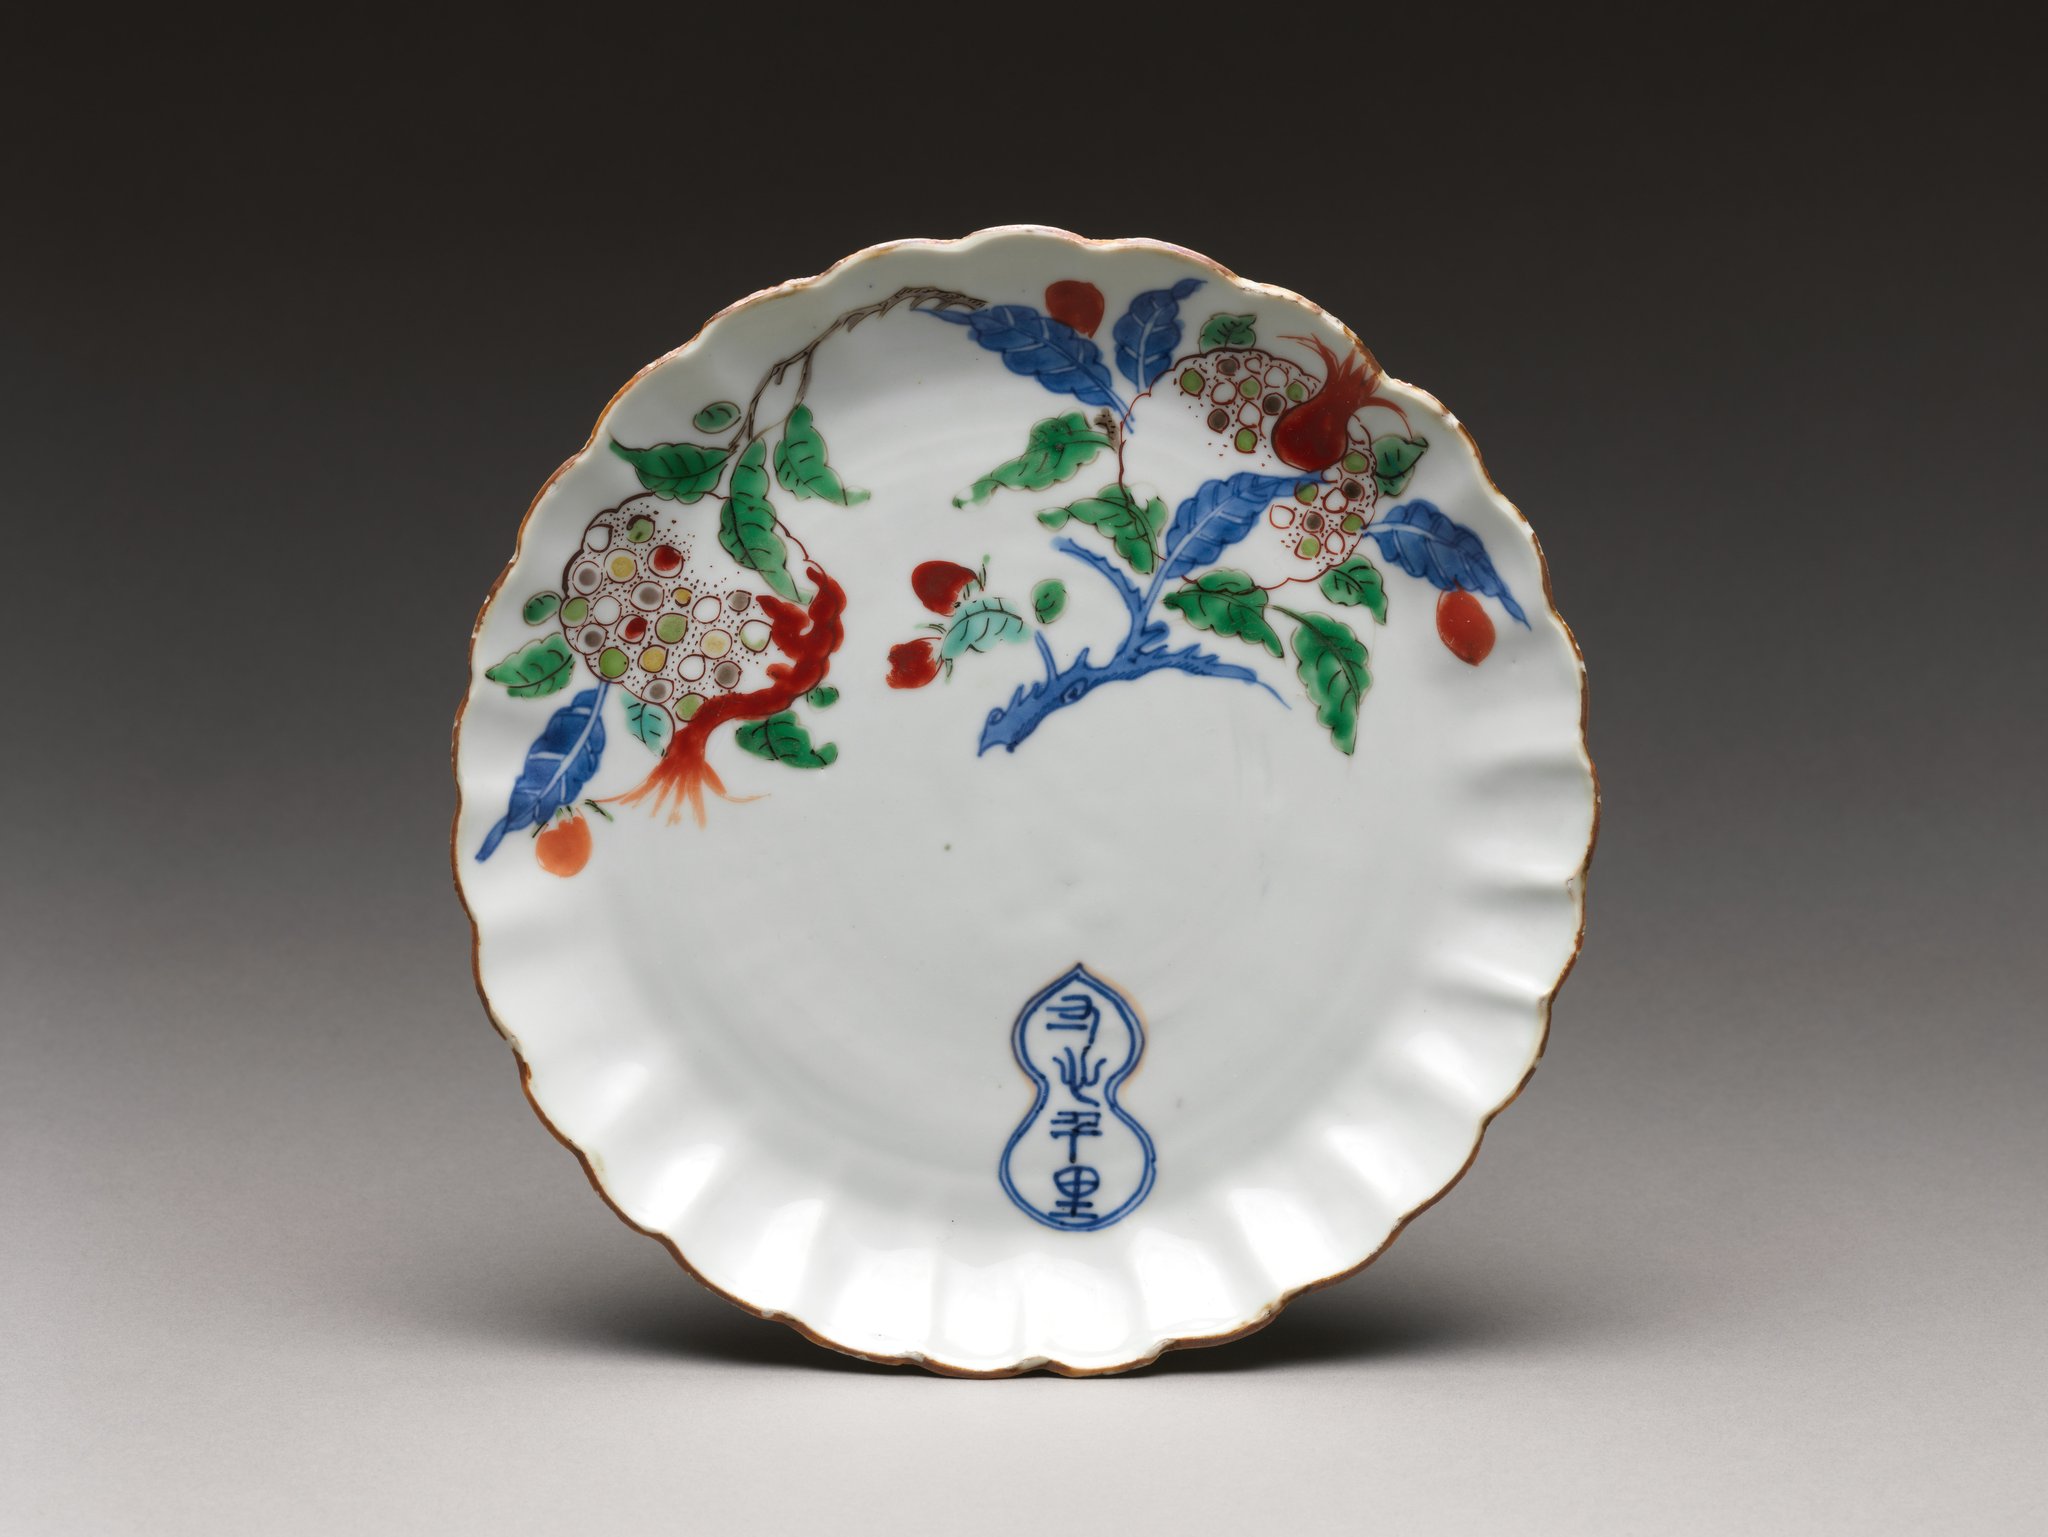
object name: dish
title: Dish with Pomegranates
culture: chinese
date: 1634-1666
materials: cobalt, enamel, glaze, porcelain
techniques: painting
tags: pomegranates,leaves